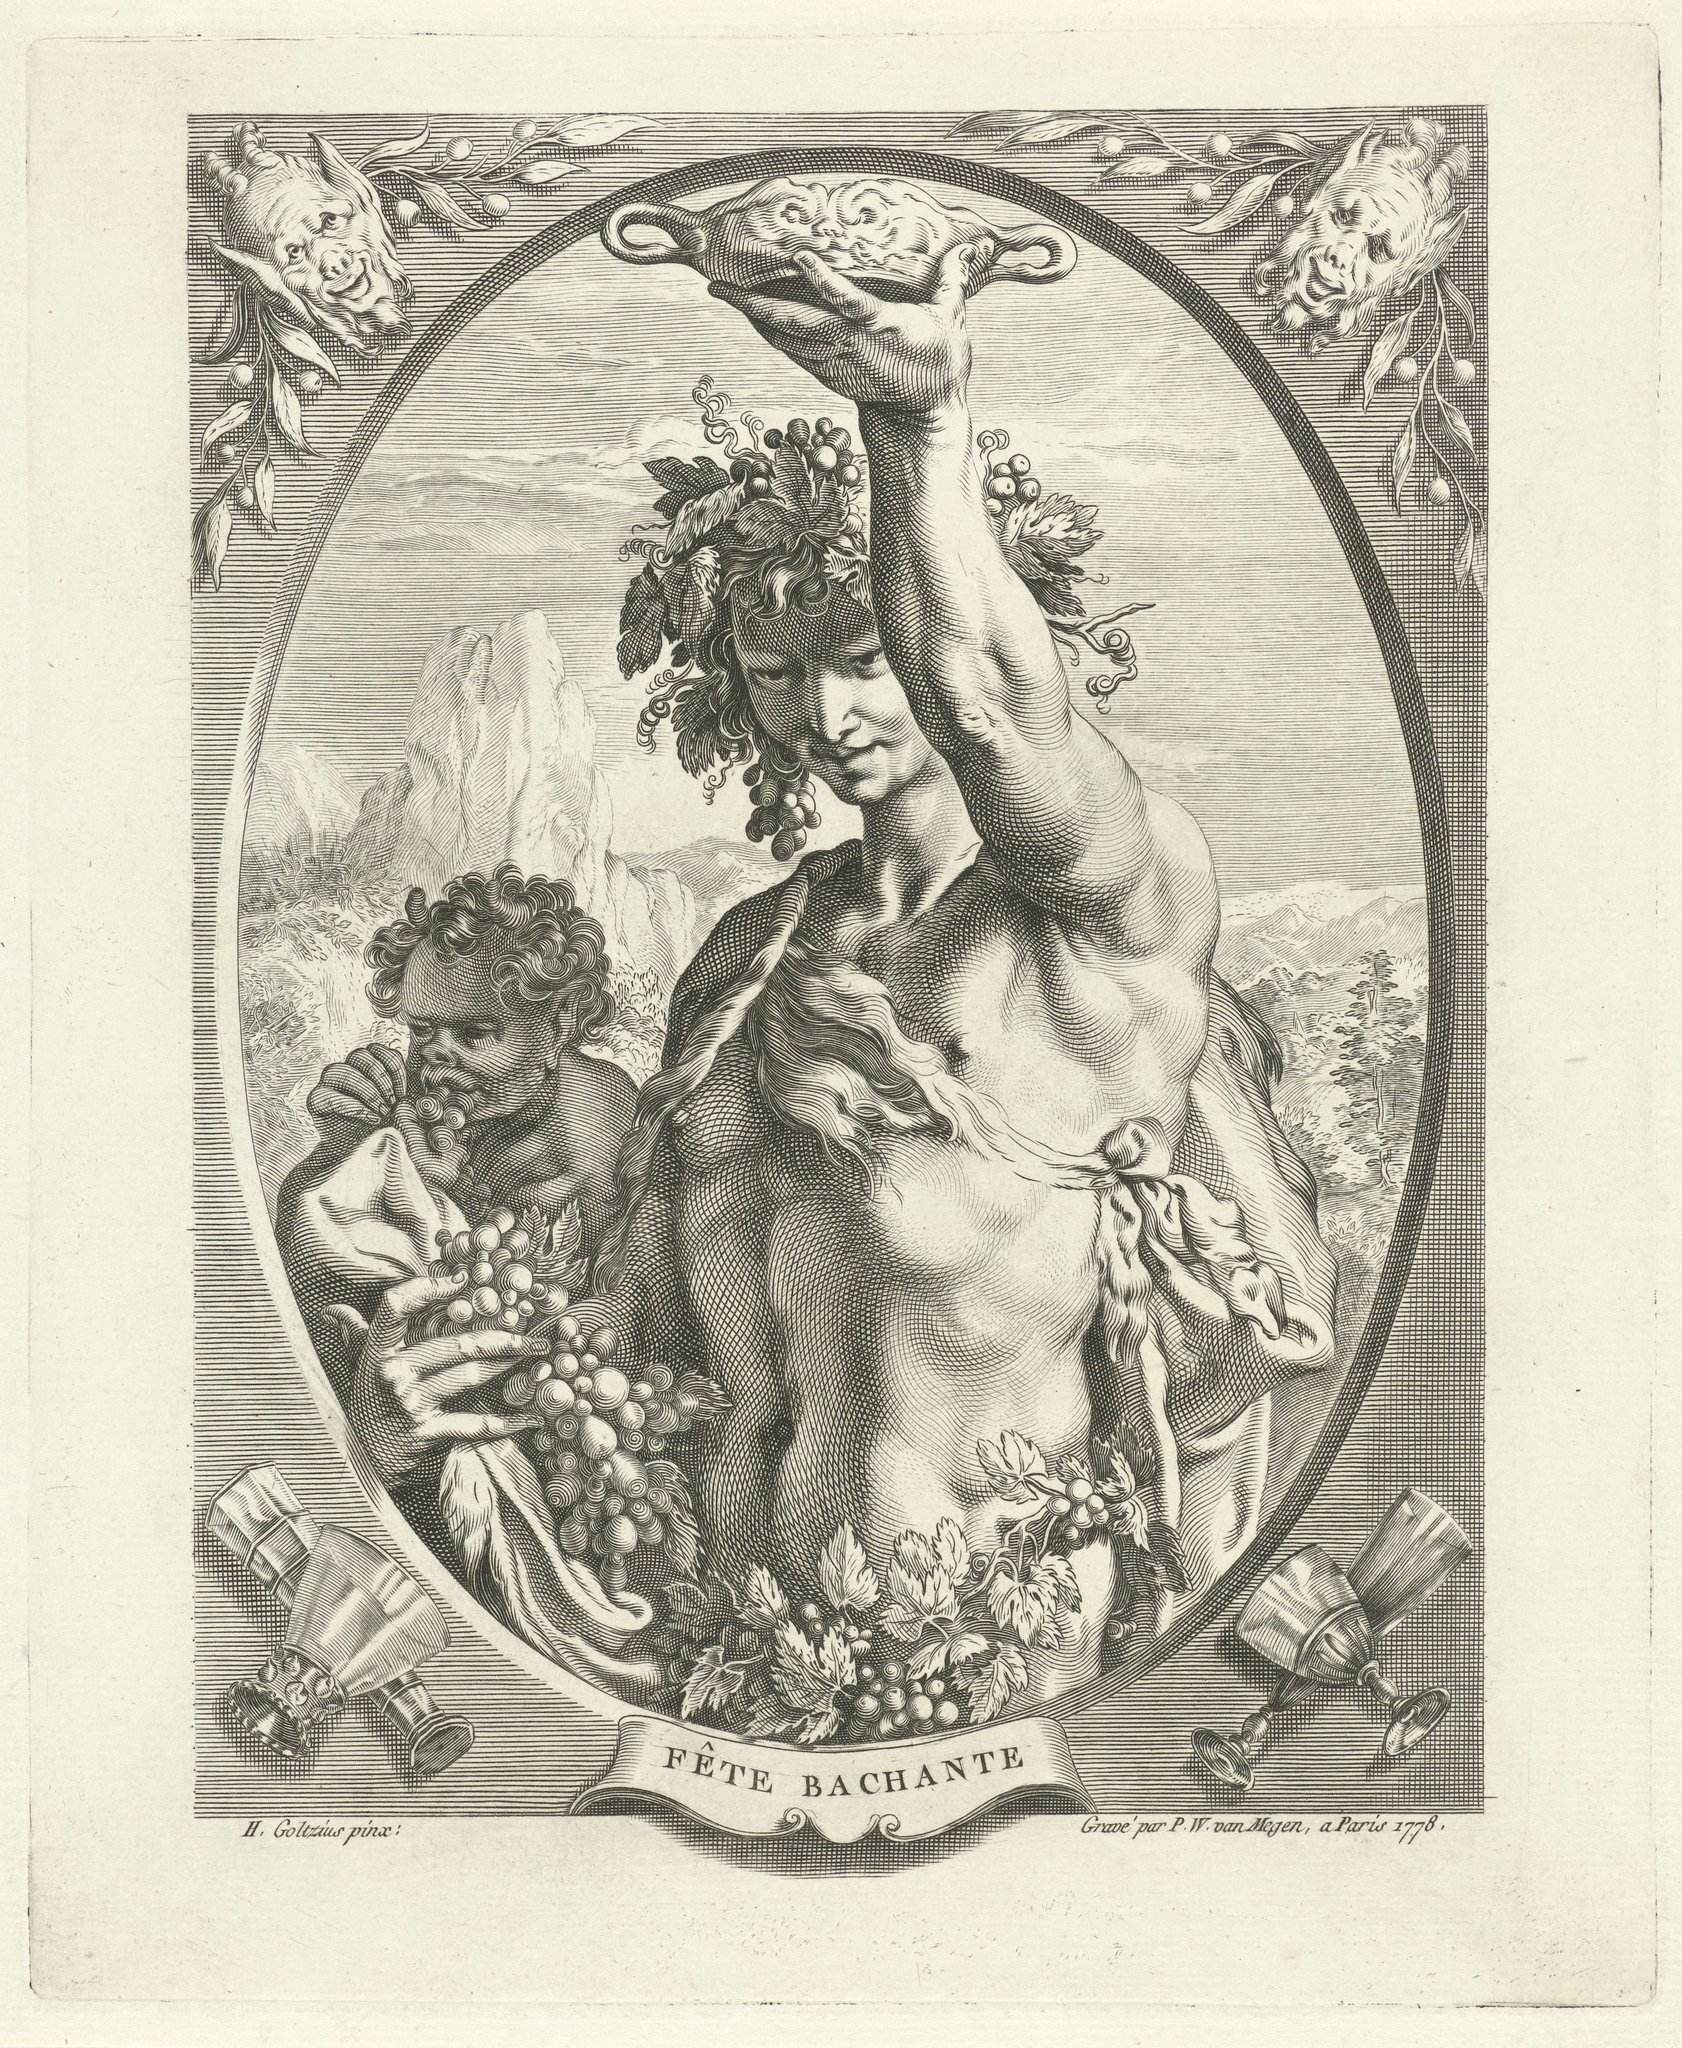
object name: print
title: Fête Bachante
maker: pieter willem van megen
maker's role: print maker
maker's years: 1750-1785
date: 1778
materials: paper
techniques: engraving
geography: paris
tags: (story of) bacchus (dionysus), liber, satyr(s) (in general), glass, rummer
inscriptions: collector's mark: Lugt 240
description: Bacchus heft zijn drinknap. Hij draagt een kroon van druiven en wingerdbladeren op zijn hoofd en een geitenhuid om zijn schouders. Achter hem een druiven etende sater. Op de achtergrond een berglandschap. De bovenhoeken van de lijst zijn versierd met de hoofden van saters, de onderhoeken met drinkglazen.